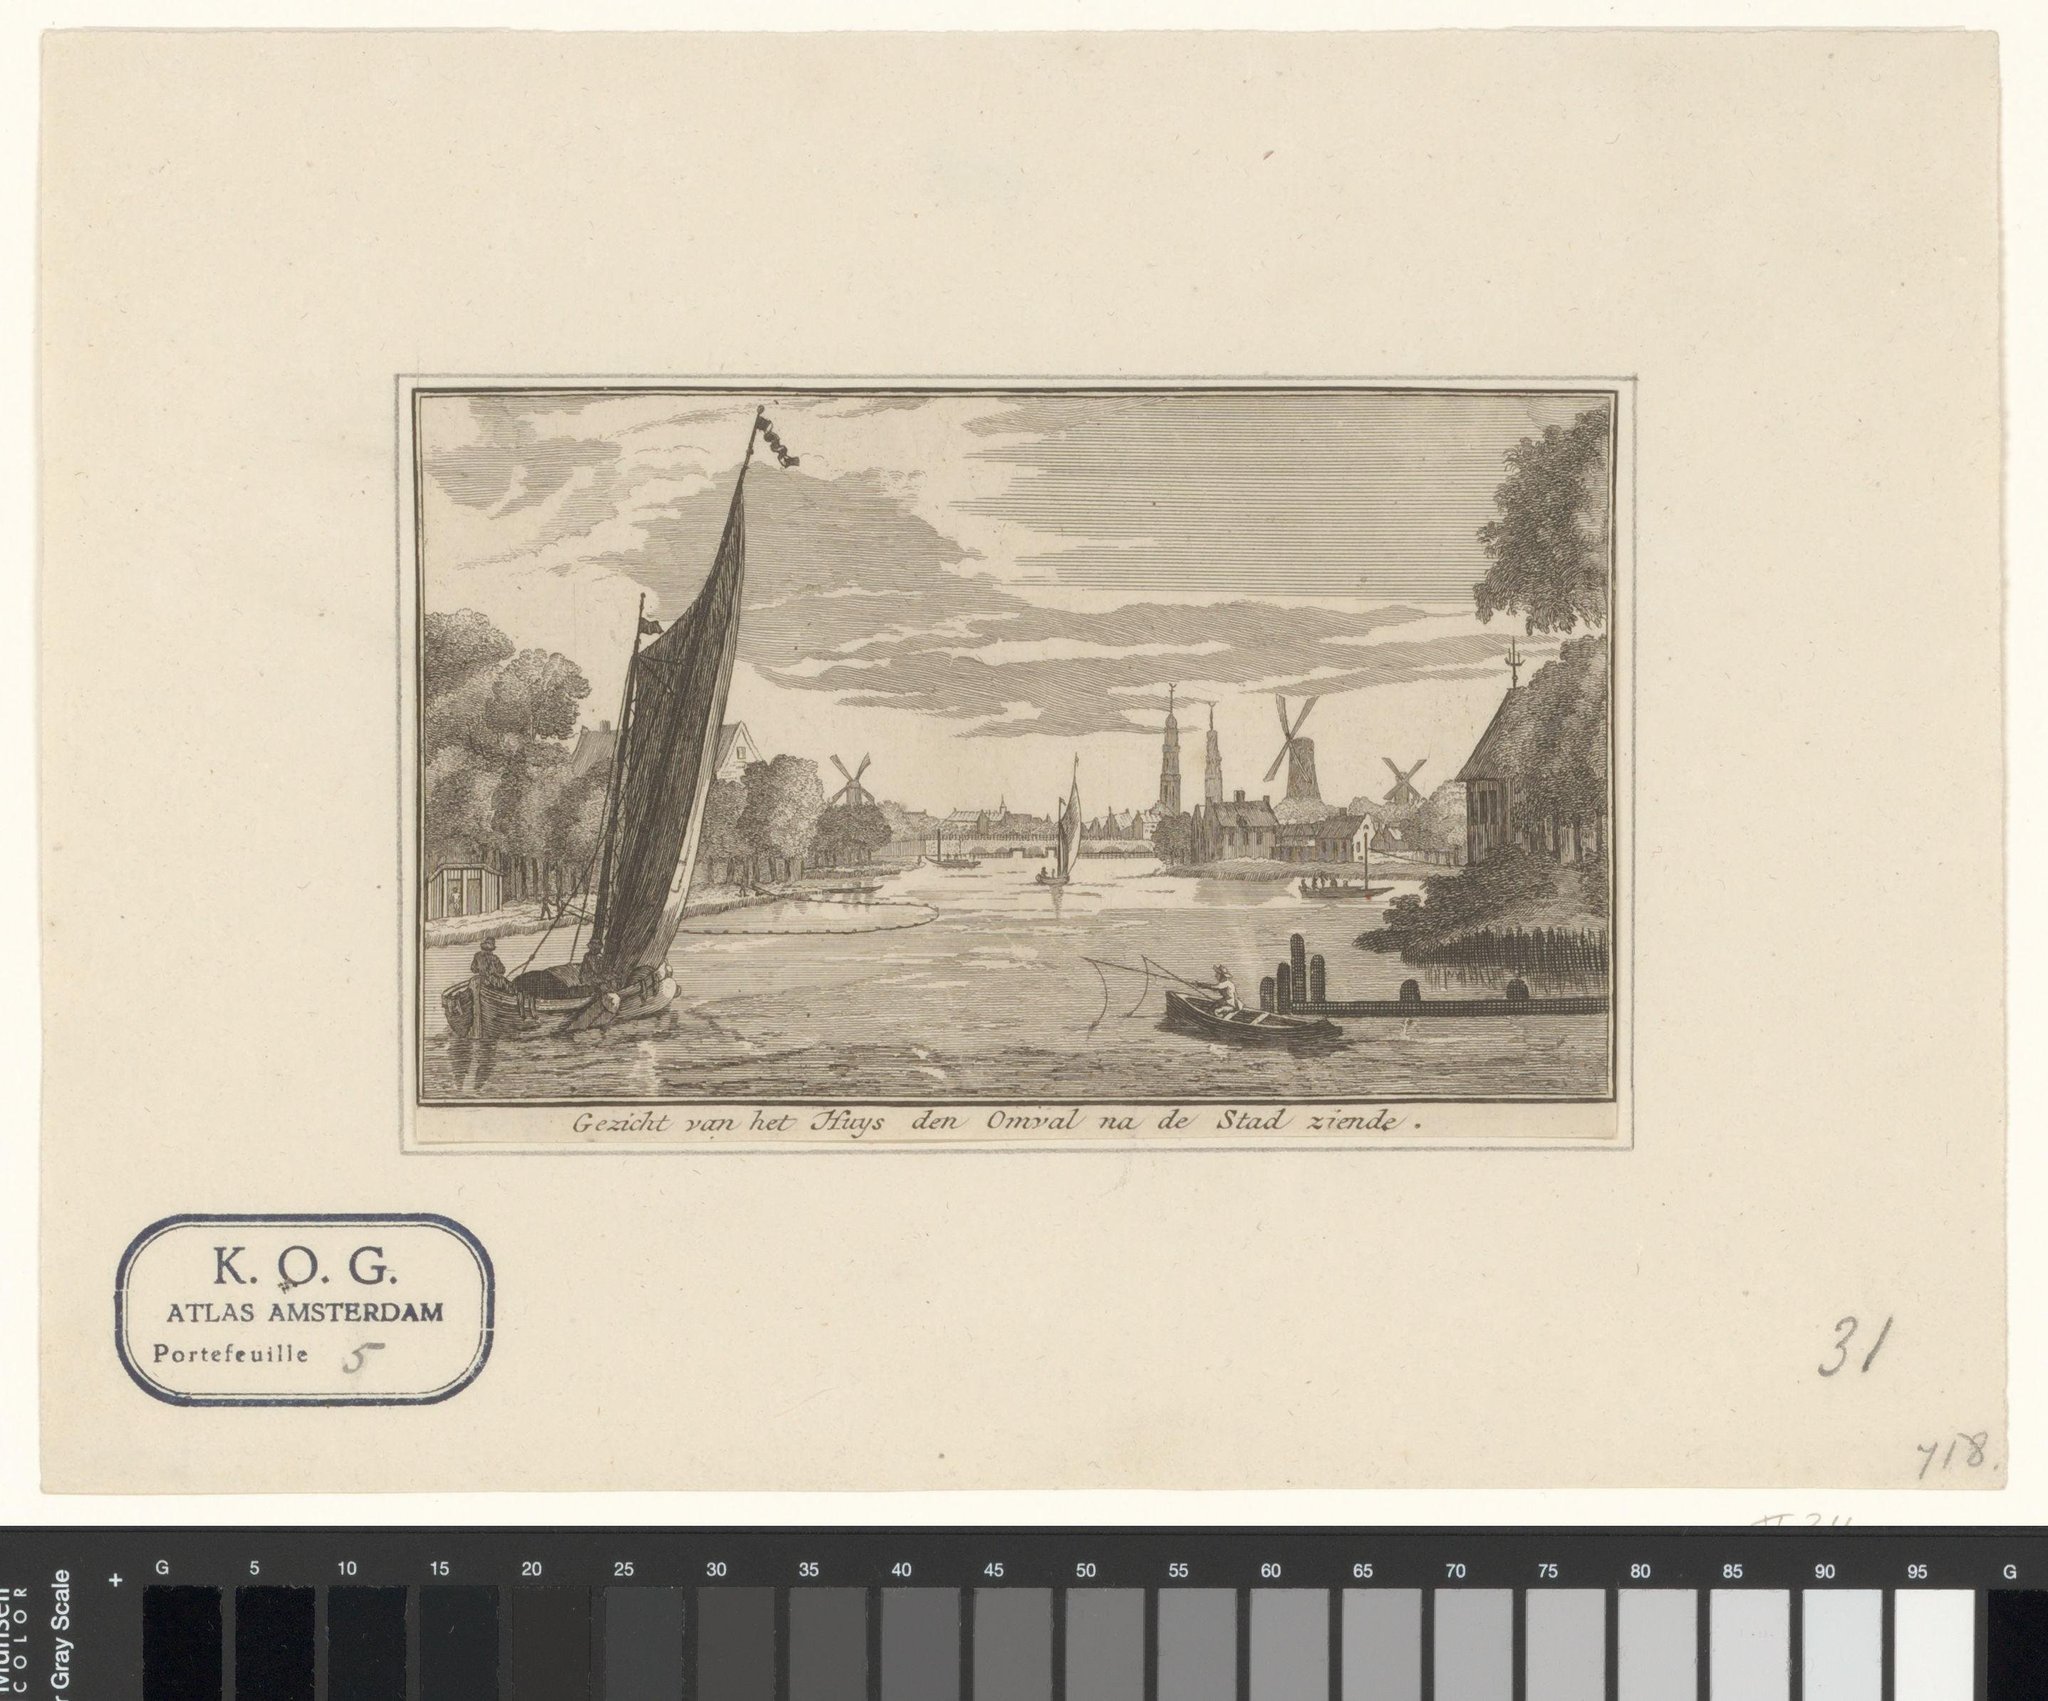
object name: print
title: Gezicht op de Amstel vanaf buitenplaats De Omval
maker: Anonymous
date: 1700-1799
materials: paper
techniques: etching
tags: sailing-ship, sailing-boat, city-view in general; 'veduta', river, windmill in landscape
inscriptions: collector's mark: ‘5’ Lugt 1641b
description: Onderwerpsrubriek binnen de Atlas Amsterdam: Amstel buiten de stad, Amsteldijk.